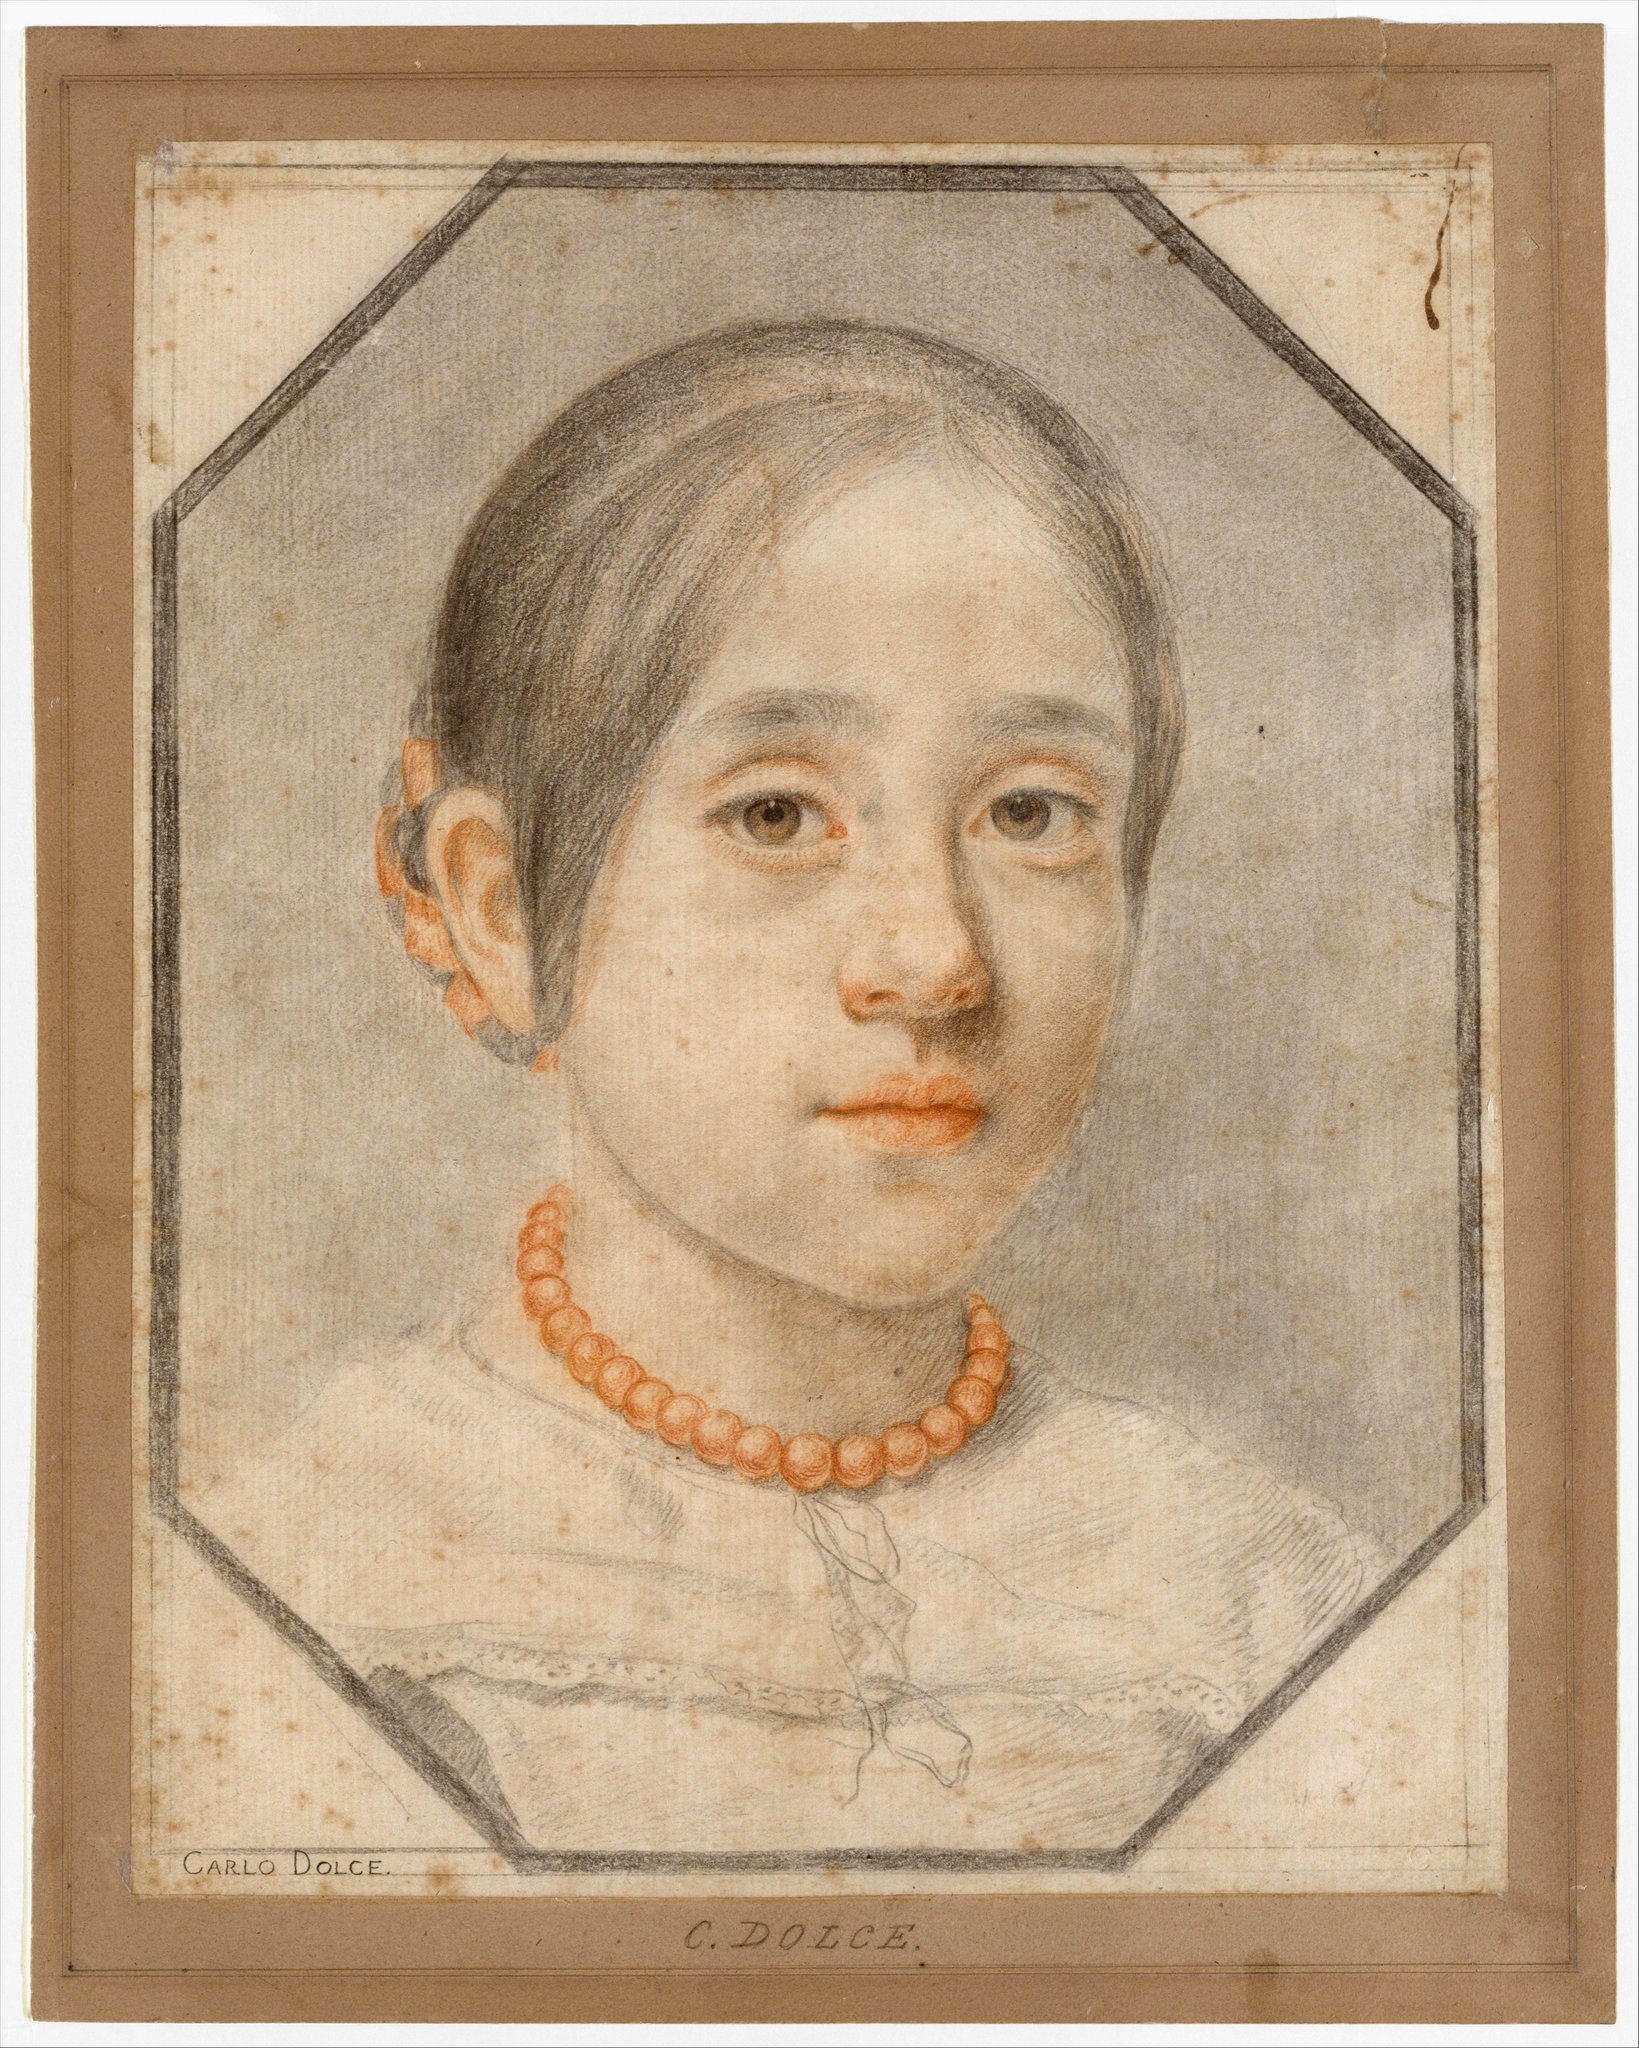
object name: drawing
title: Portrait of the Artist's Daughter Agata Dolci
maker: carlo dolci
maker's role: artist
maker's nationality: italian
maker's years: 1616-1687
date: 1676-1680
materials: chalk, paper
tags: girls,portraits